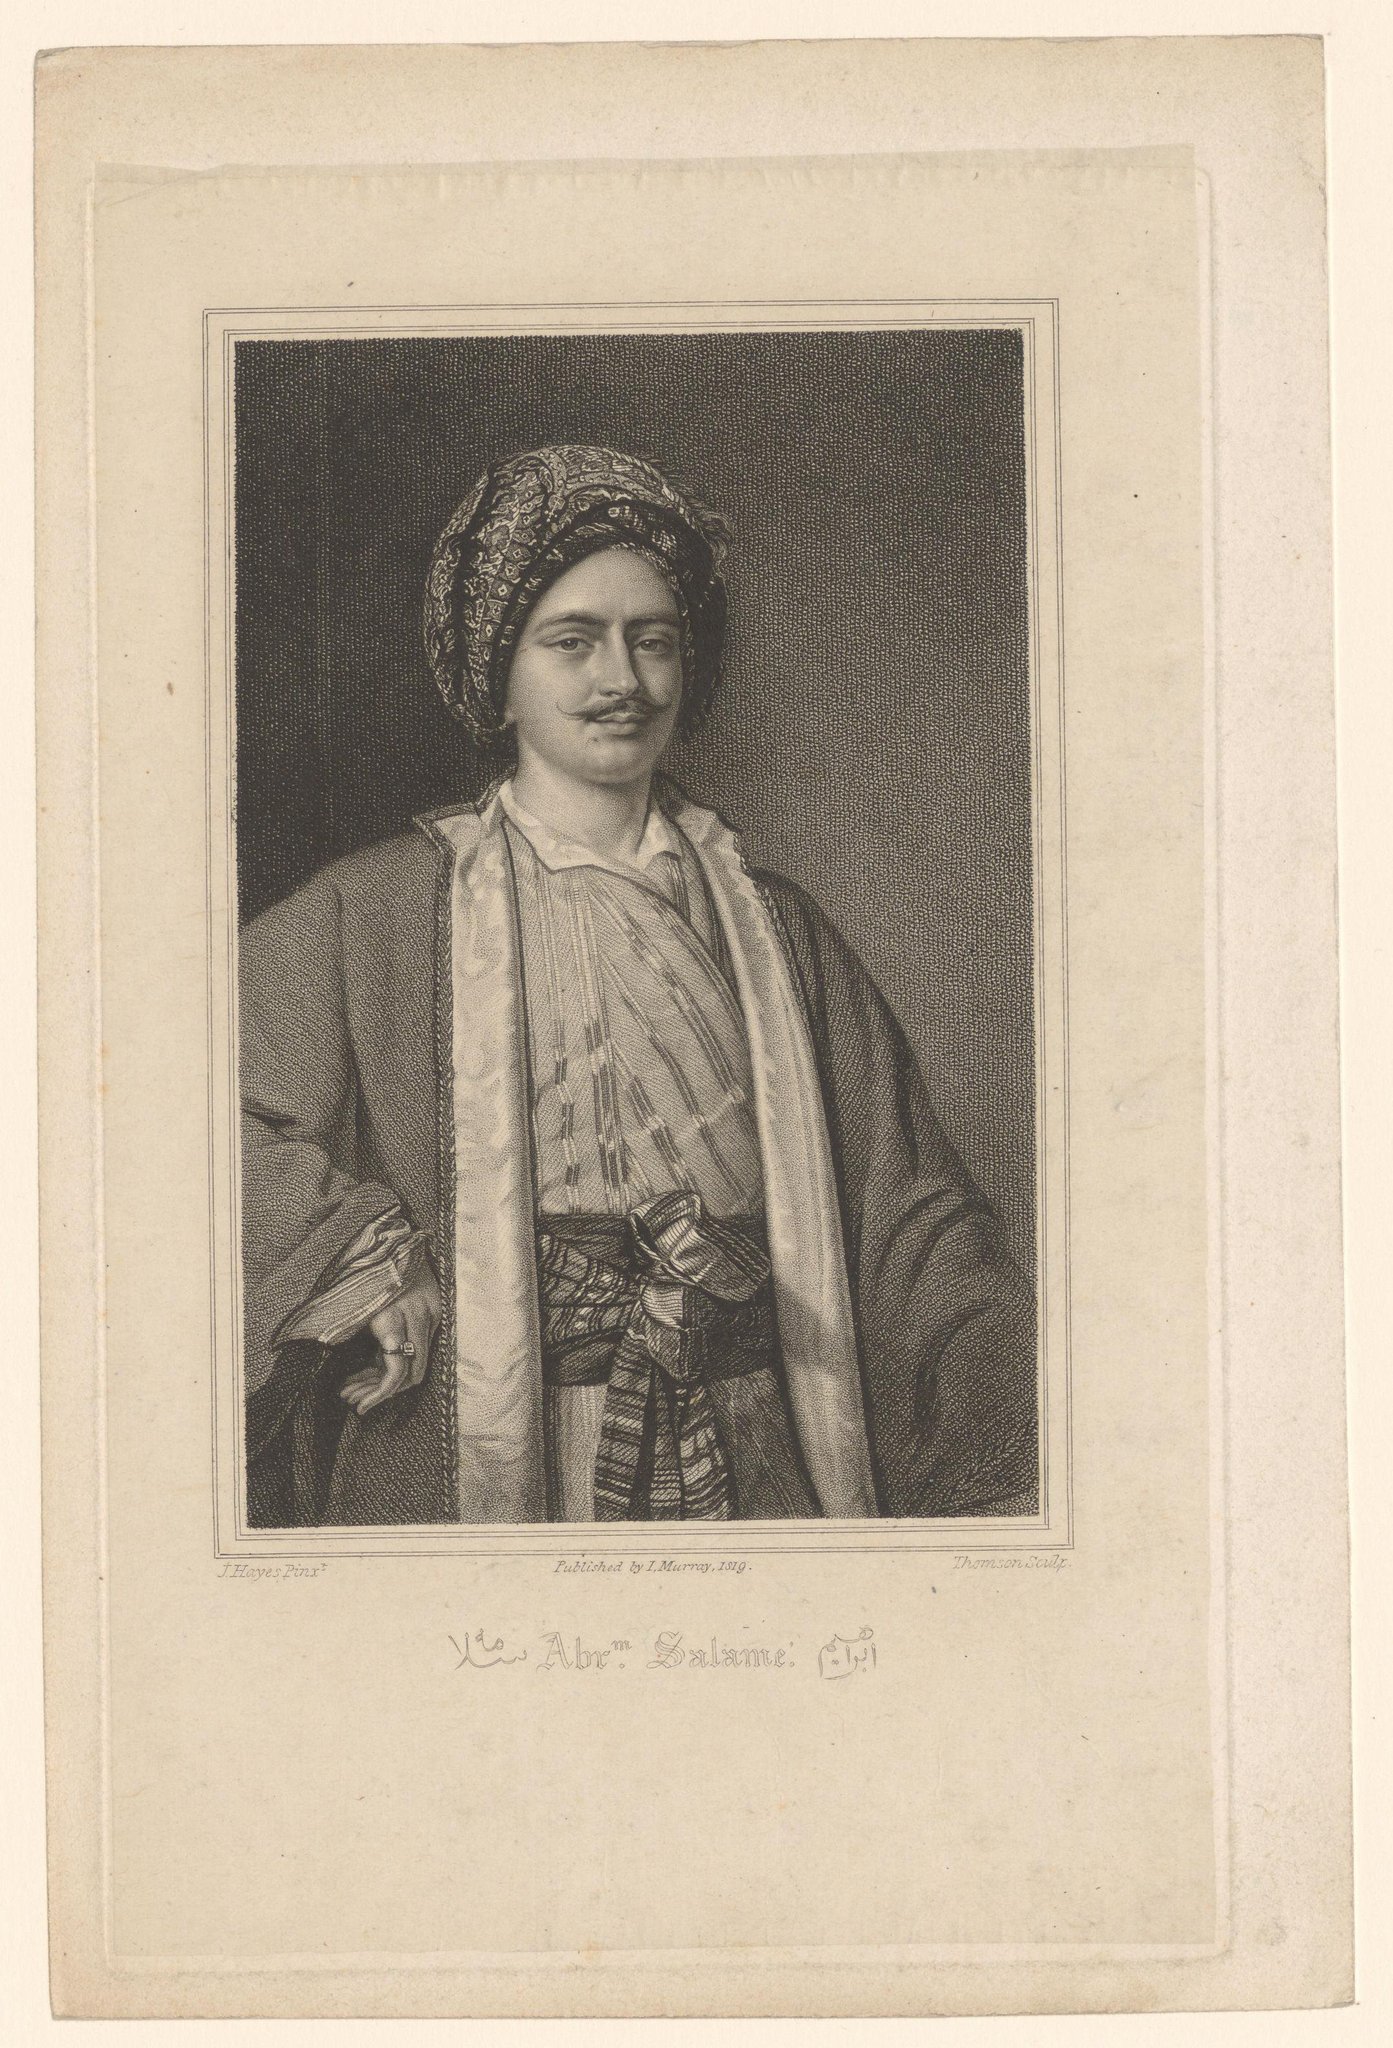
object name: print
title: Portret van Abraham Salamé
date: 1819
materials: paper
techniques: etching, engraving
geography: london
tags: historical persons, portrait of a writer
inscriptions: collector's mark: Lugt 2228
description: Prent uit: Salamé, Abraham. A narrative of the Expedition to Algiers in the year 1816 (...). Londen: John Murray, 1819.